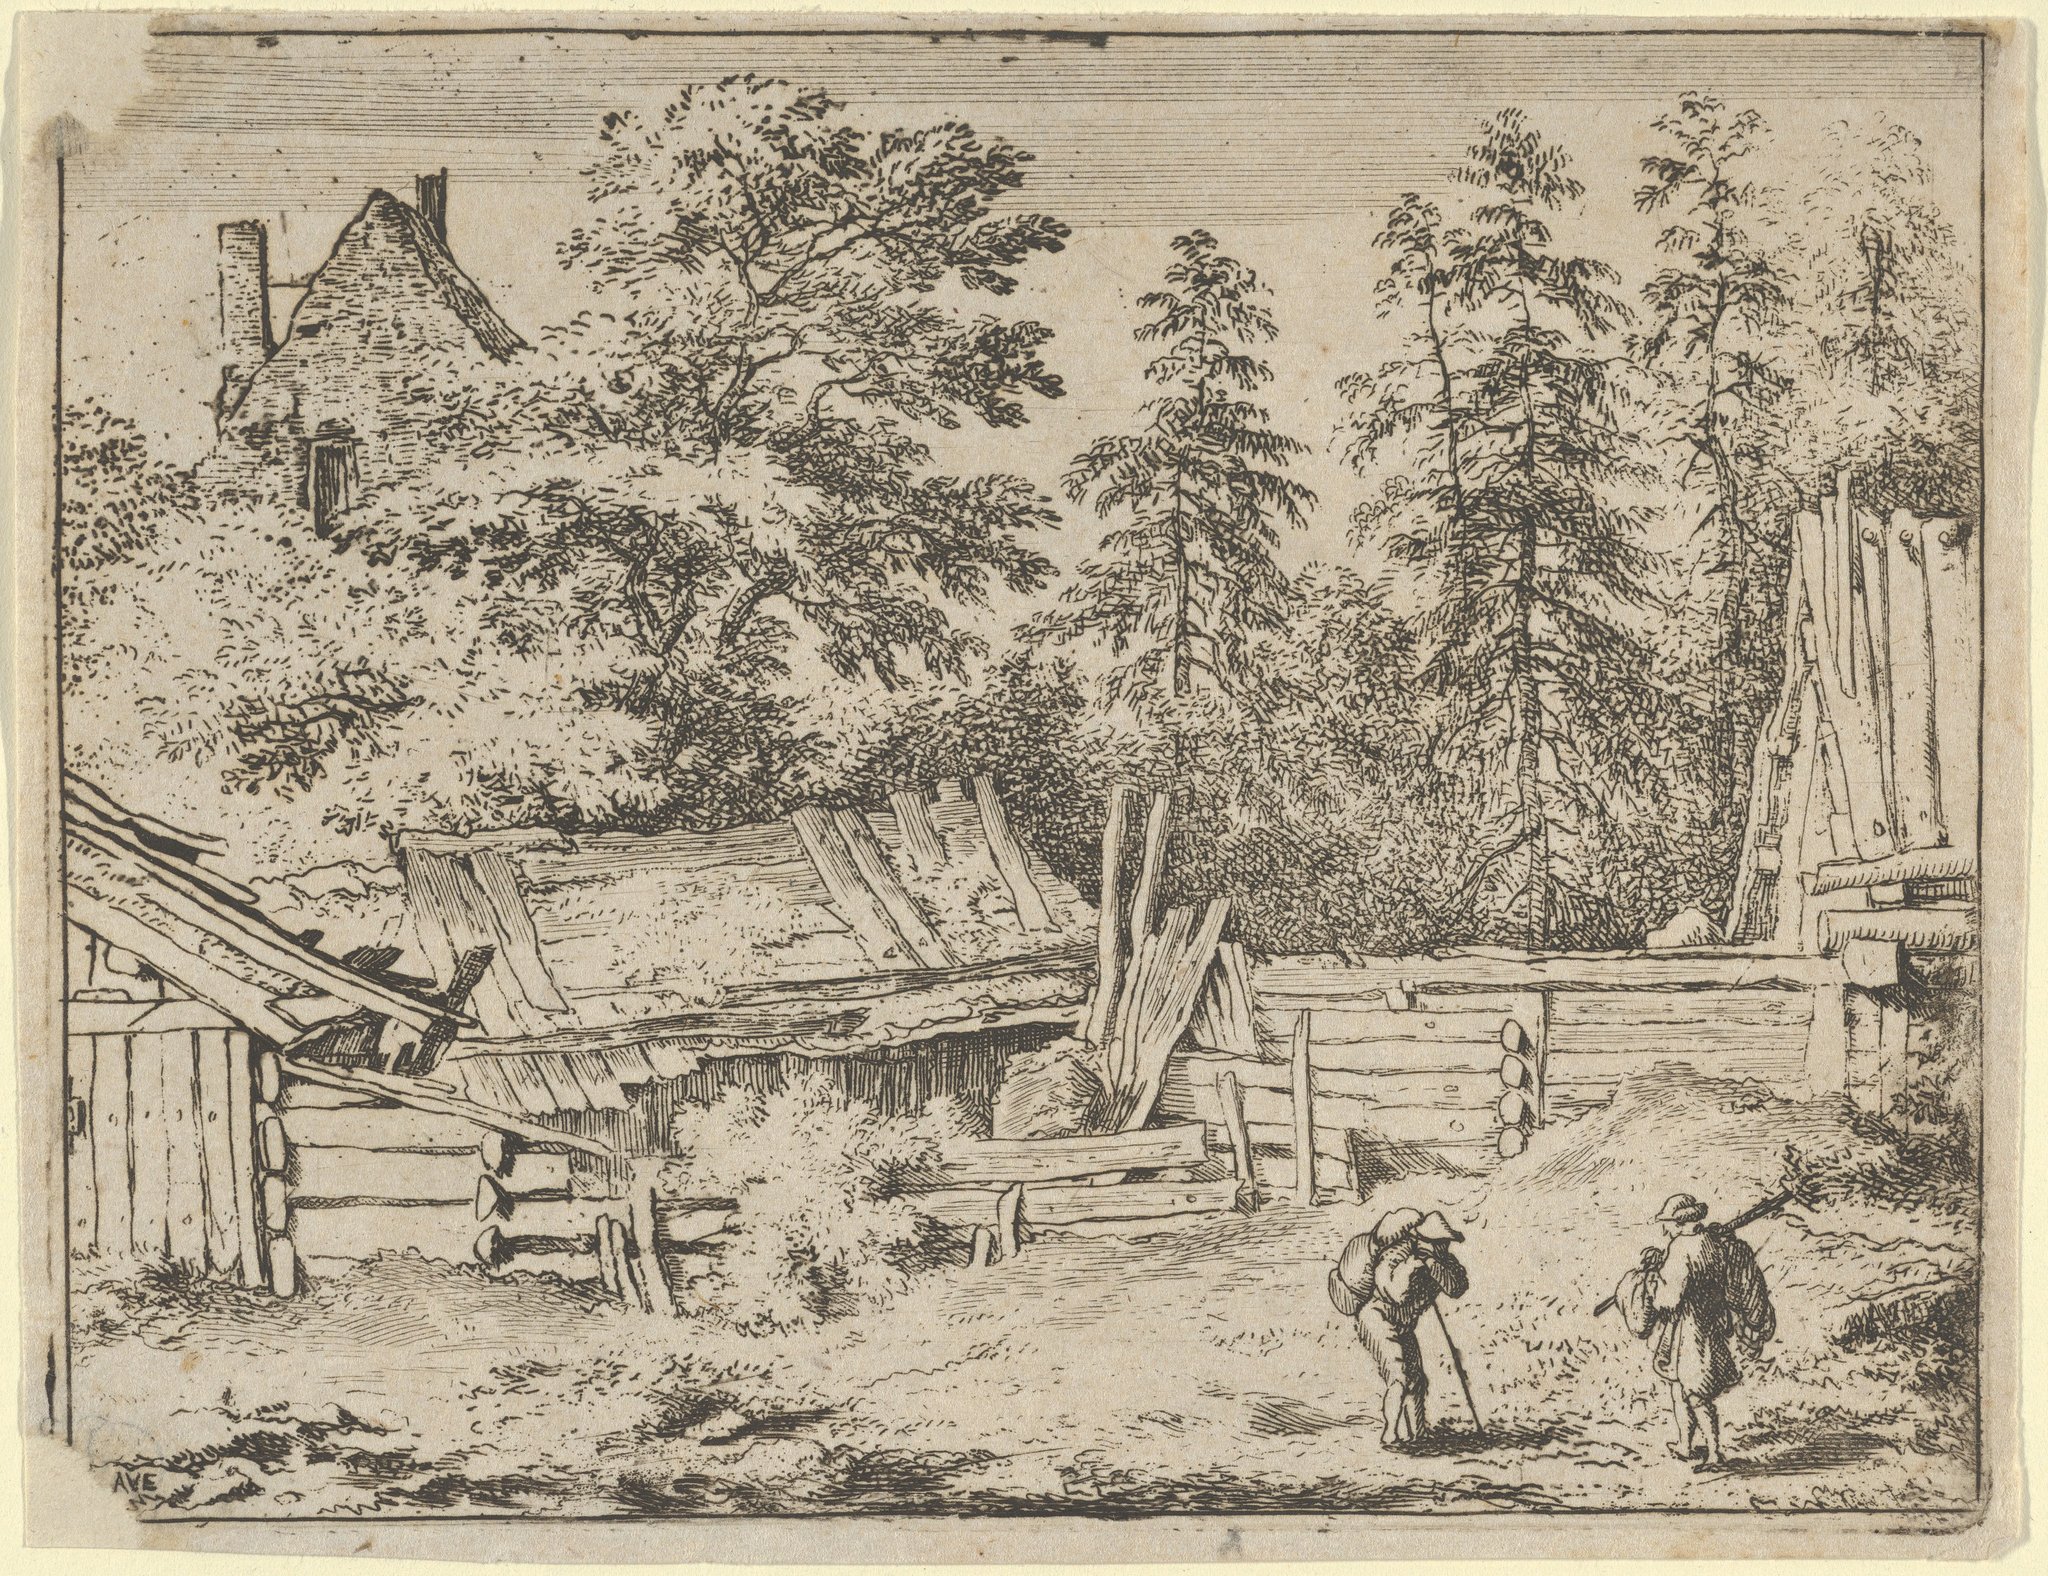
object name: print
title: The Three Cottages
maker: allart van everdingen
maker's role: artist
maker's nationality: dutch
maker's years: 1621-1675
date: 1601-1700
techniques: engraving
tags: houses,men,trees